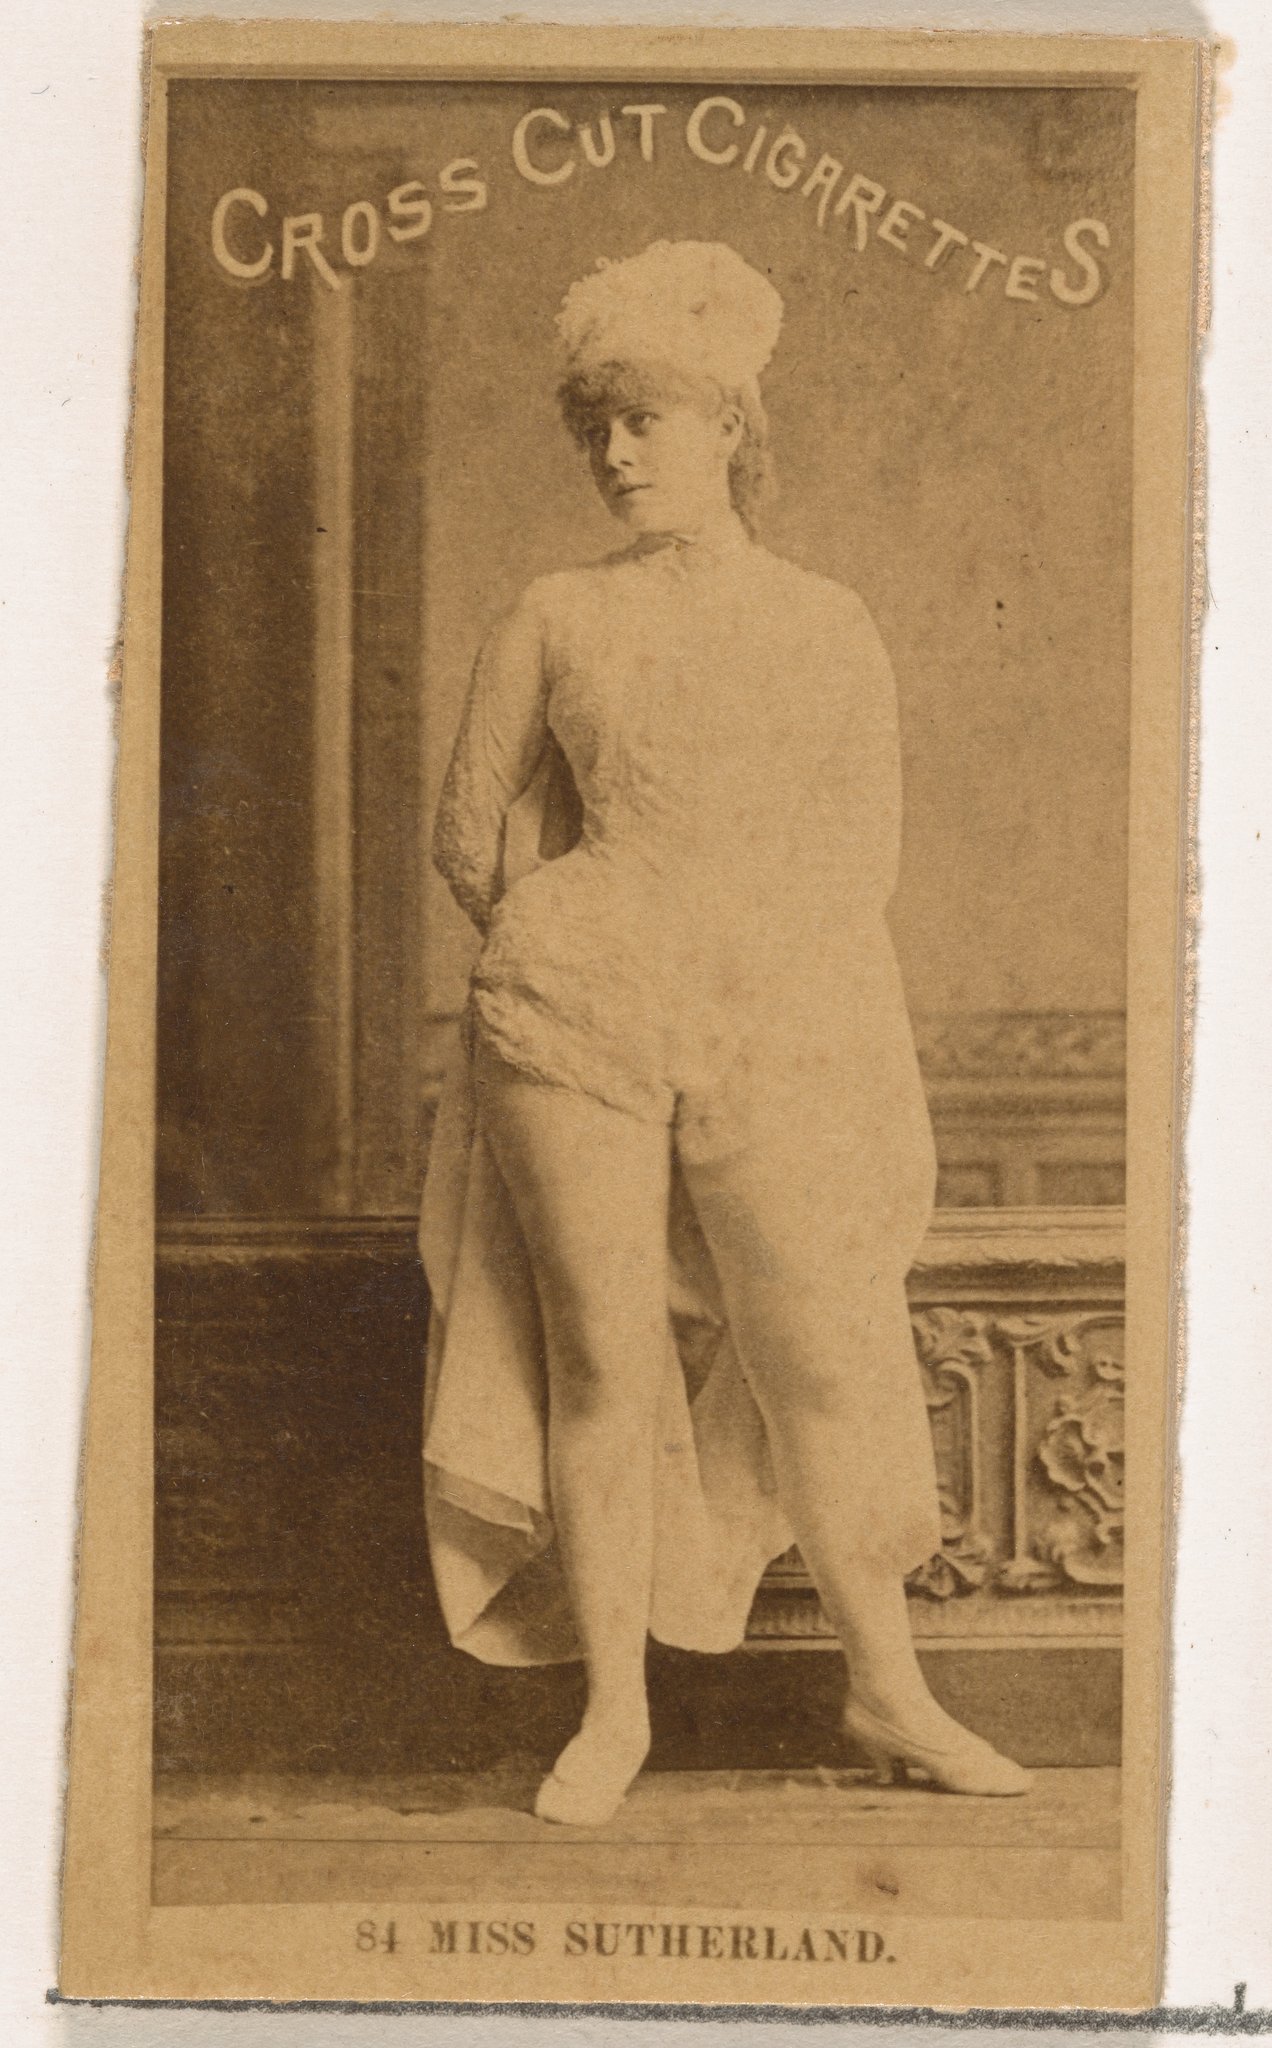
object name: print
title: Card Number 81, Miss Sutherland, from the Actors and Actresses series (N145-2) issued by Duke Sons & Co. to promote Cross Cut Cigarettes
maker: w. duke, sons & co.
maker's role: publisher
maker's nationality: american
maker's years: 1870-1920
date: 1880-1889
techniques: albumen silver print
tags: portraits,women,actresses